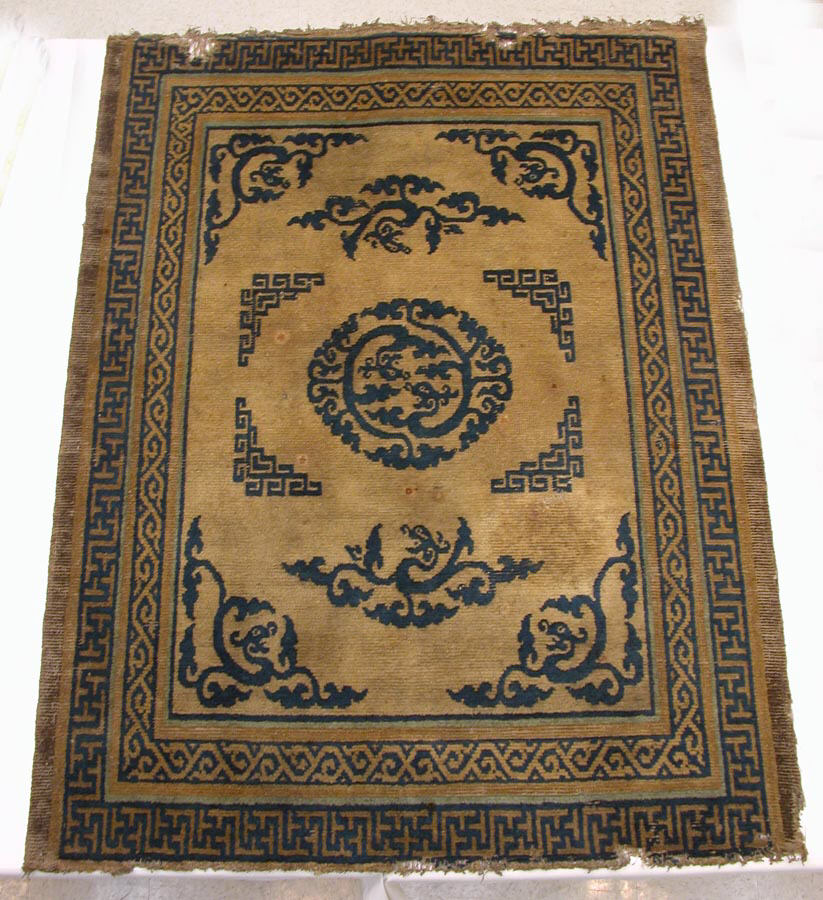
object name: kang rug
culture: chinese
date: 1701-1733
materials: cotton, wool